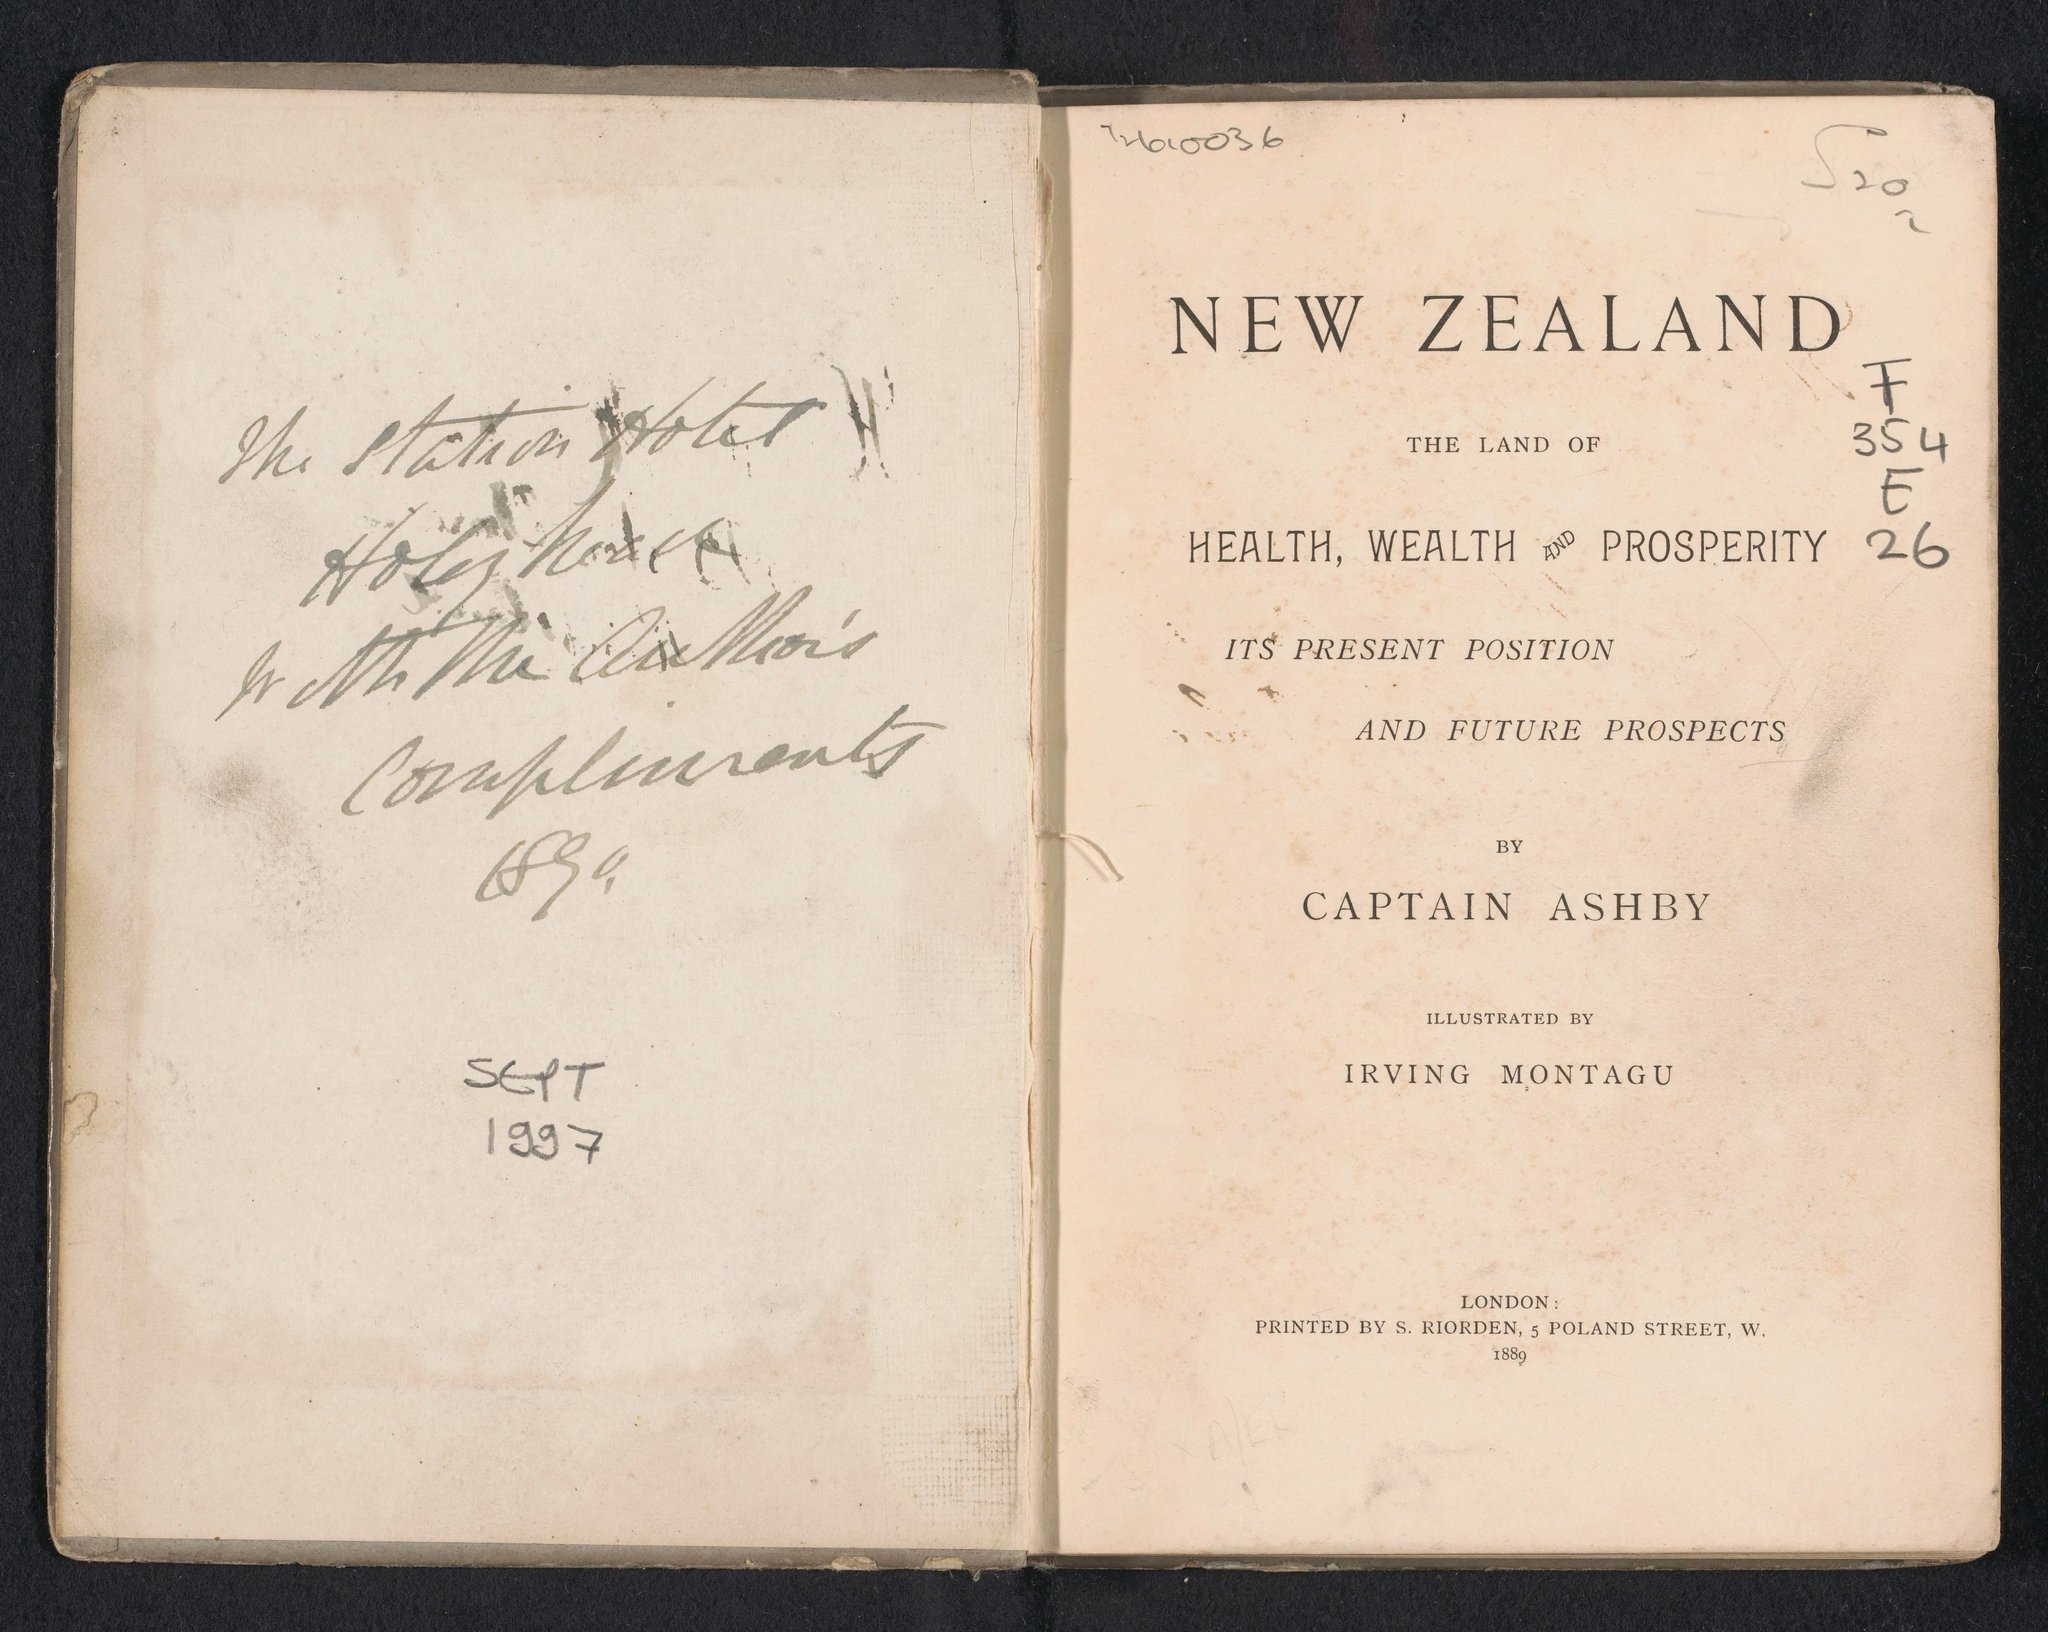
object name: book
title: New Zealand the land of health, wealth and prosperity its present position and future prospects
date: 1889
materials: cardboard, paper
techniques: printing, woodburytype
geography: london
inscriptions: inscription: ‘Hugh Roberts Boston Ferrace [...] Laud Holy head [...]’, inscription: ‘The station Hotel Holy [...] With the Author's compliments 1894’